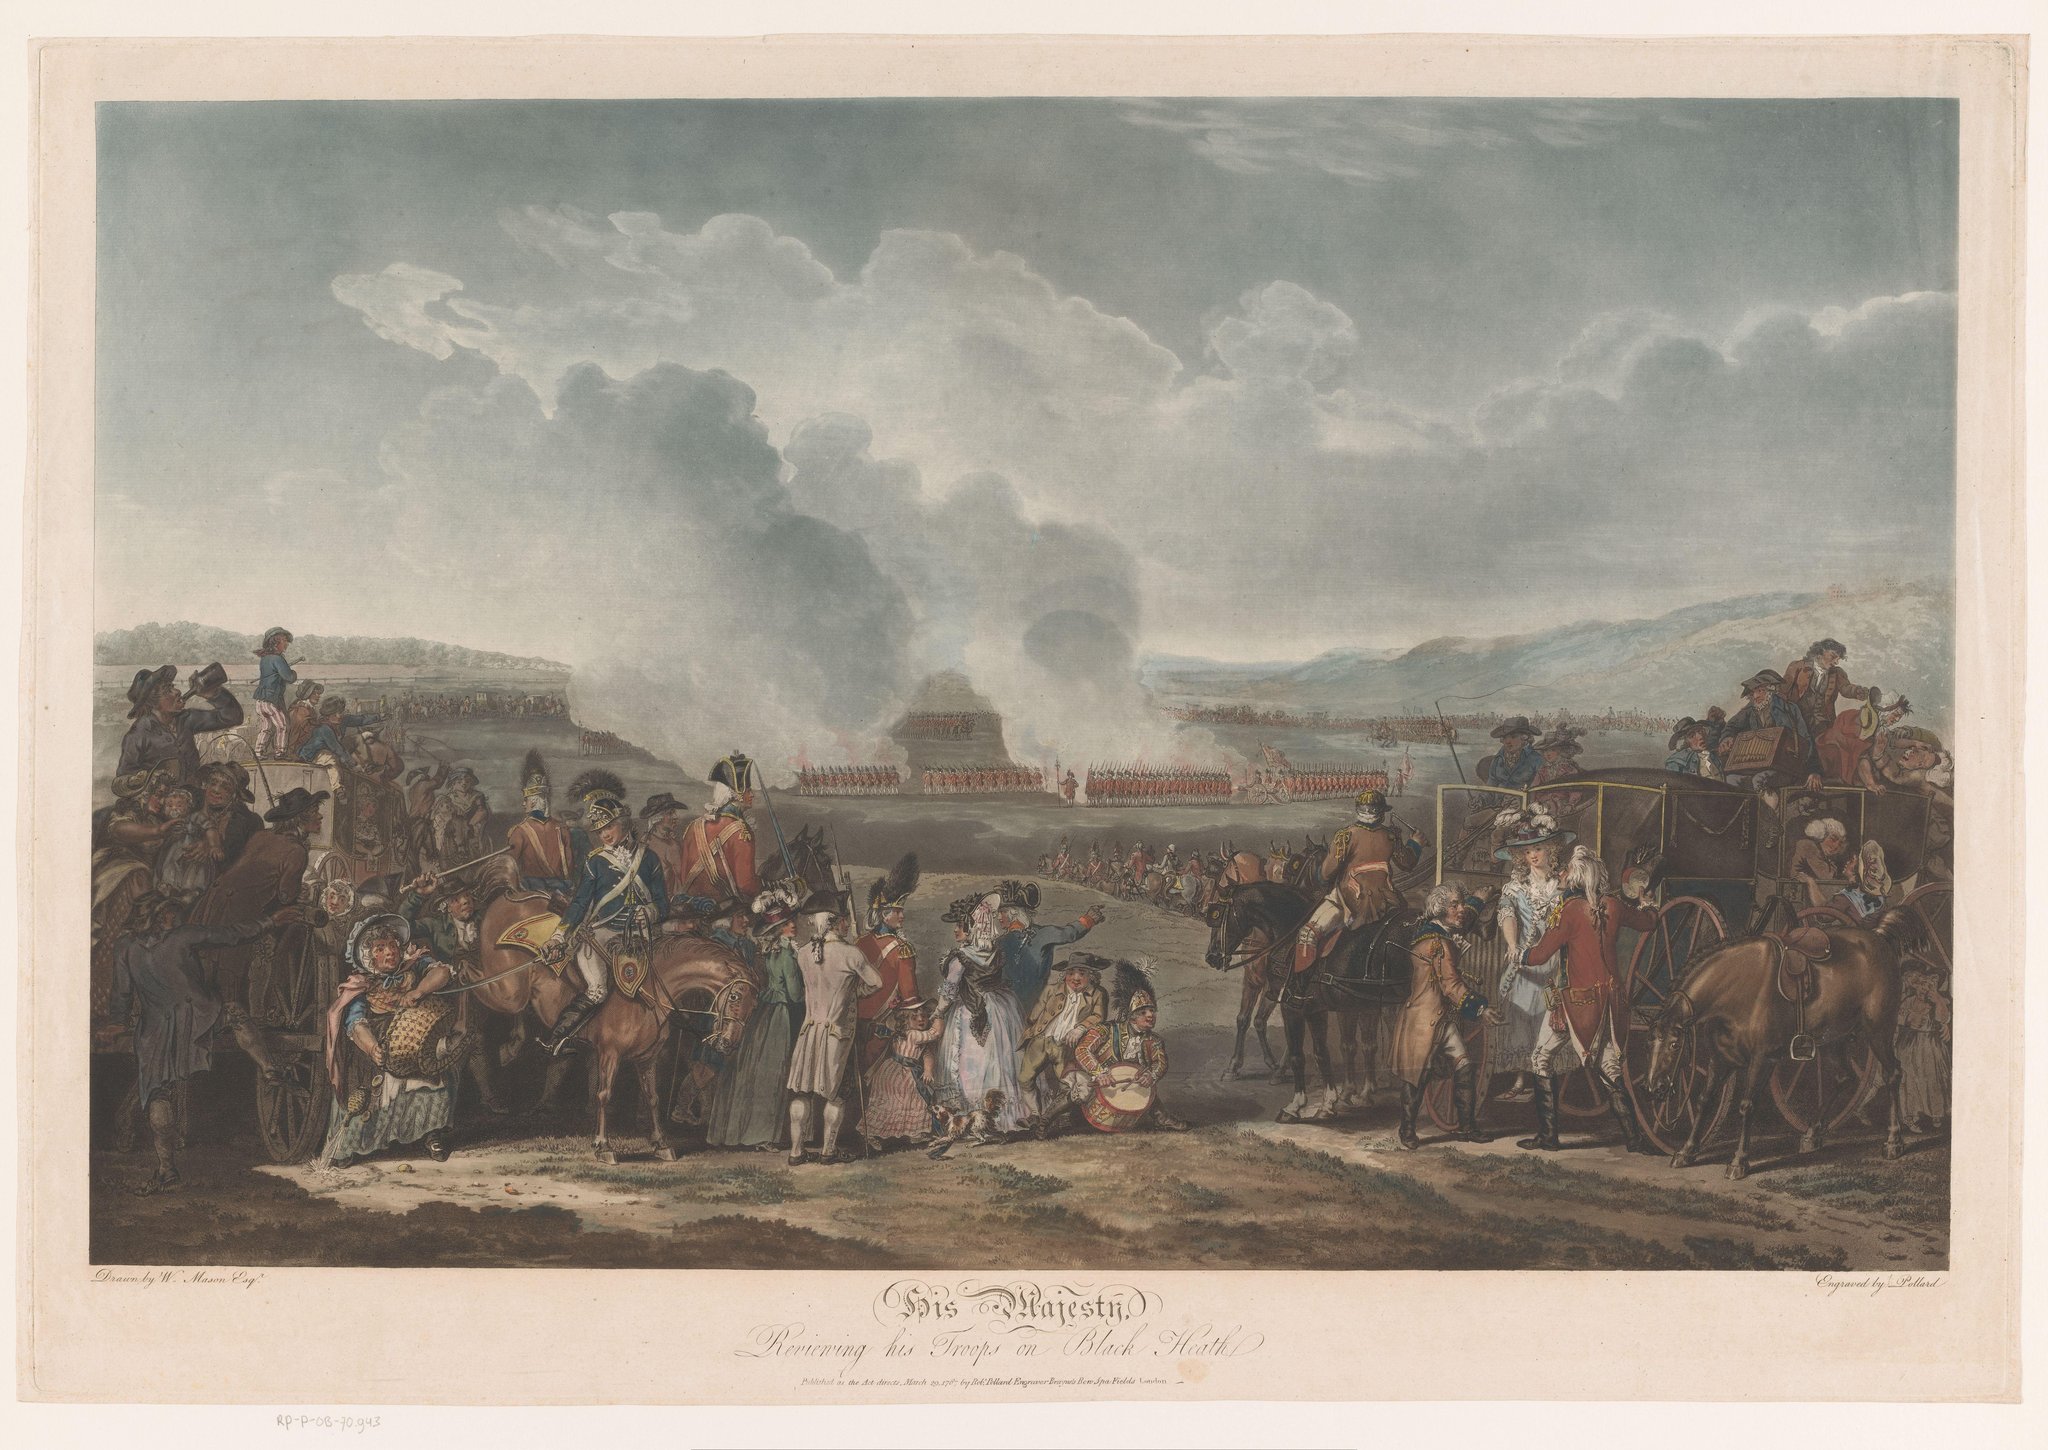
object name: print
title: His Majesty, reviewing his troops on Black Heath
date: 1703-1787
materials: paper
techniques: aquatint, engraving, etching, hand coloring, roulette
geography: london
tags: london, george iii (koning van het verenigd koninkrijk), four-wheeled, animal-drawn vehicle, e.g.: cab, carriage, coach, land forces, military parade, pageant, cannon shots (military salute)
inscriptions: collector's mark: Lugt 2228